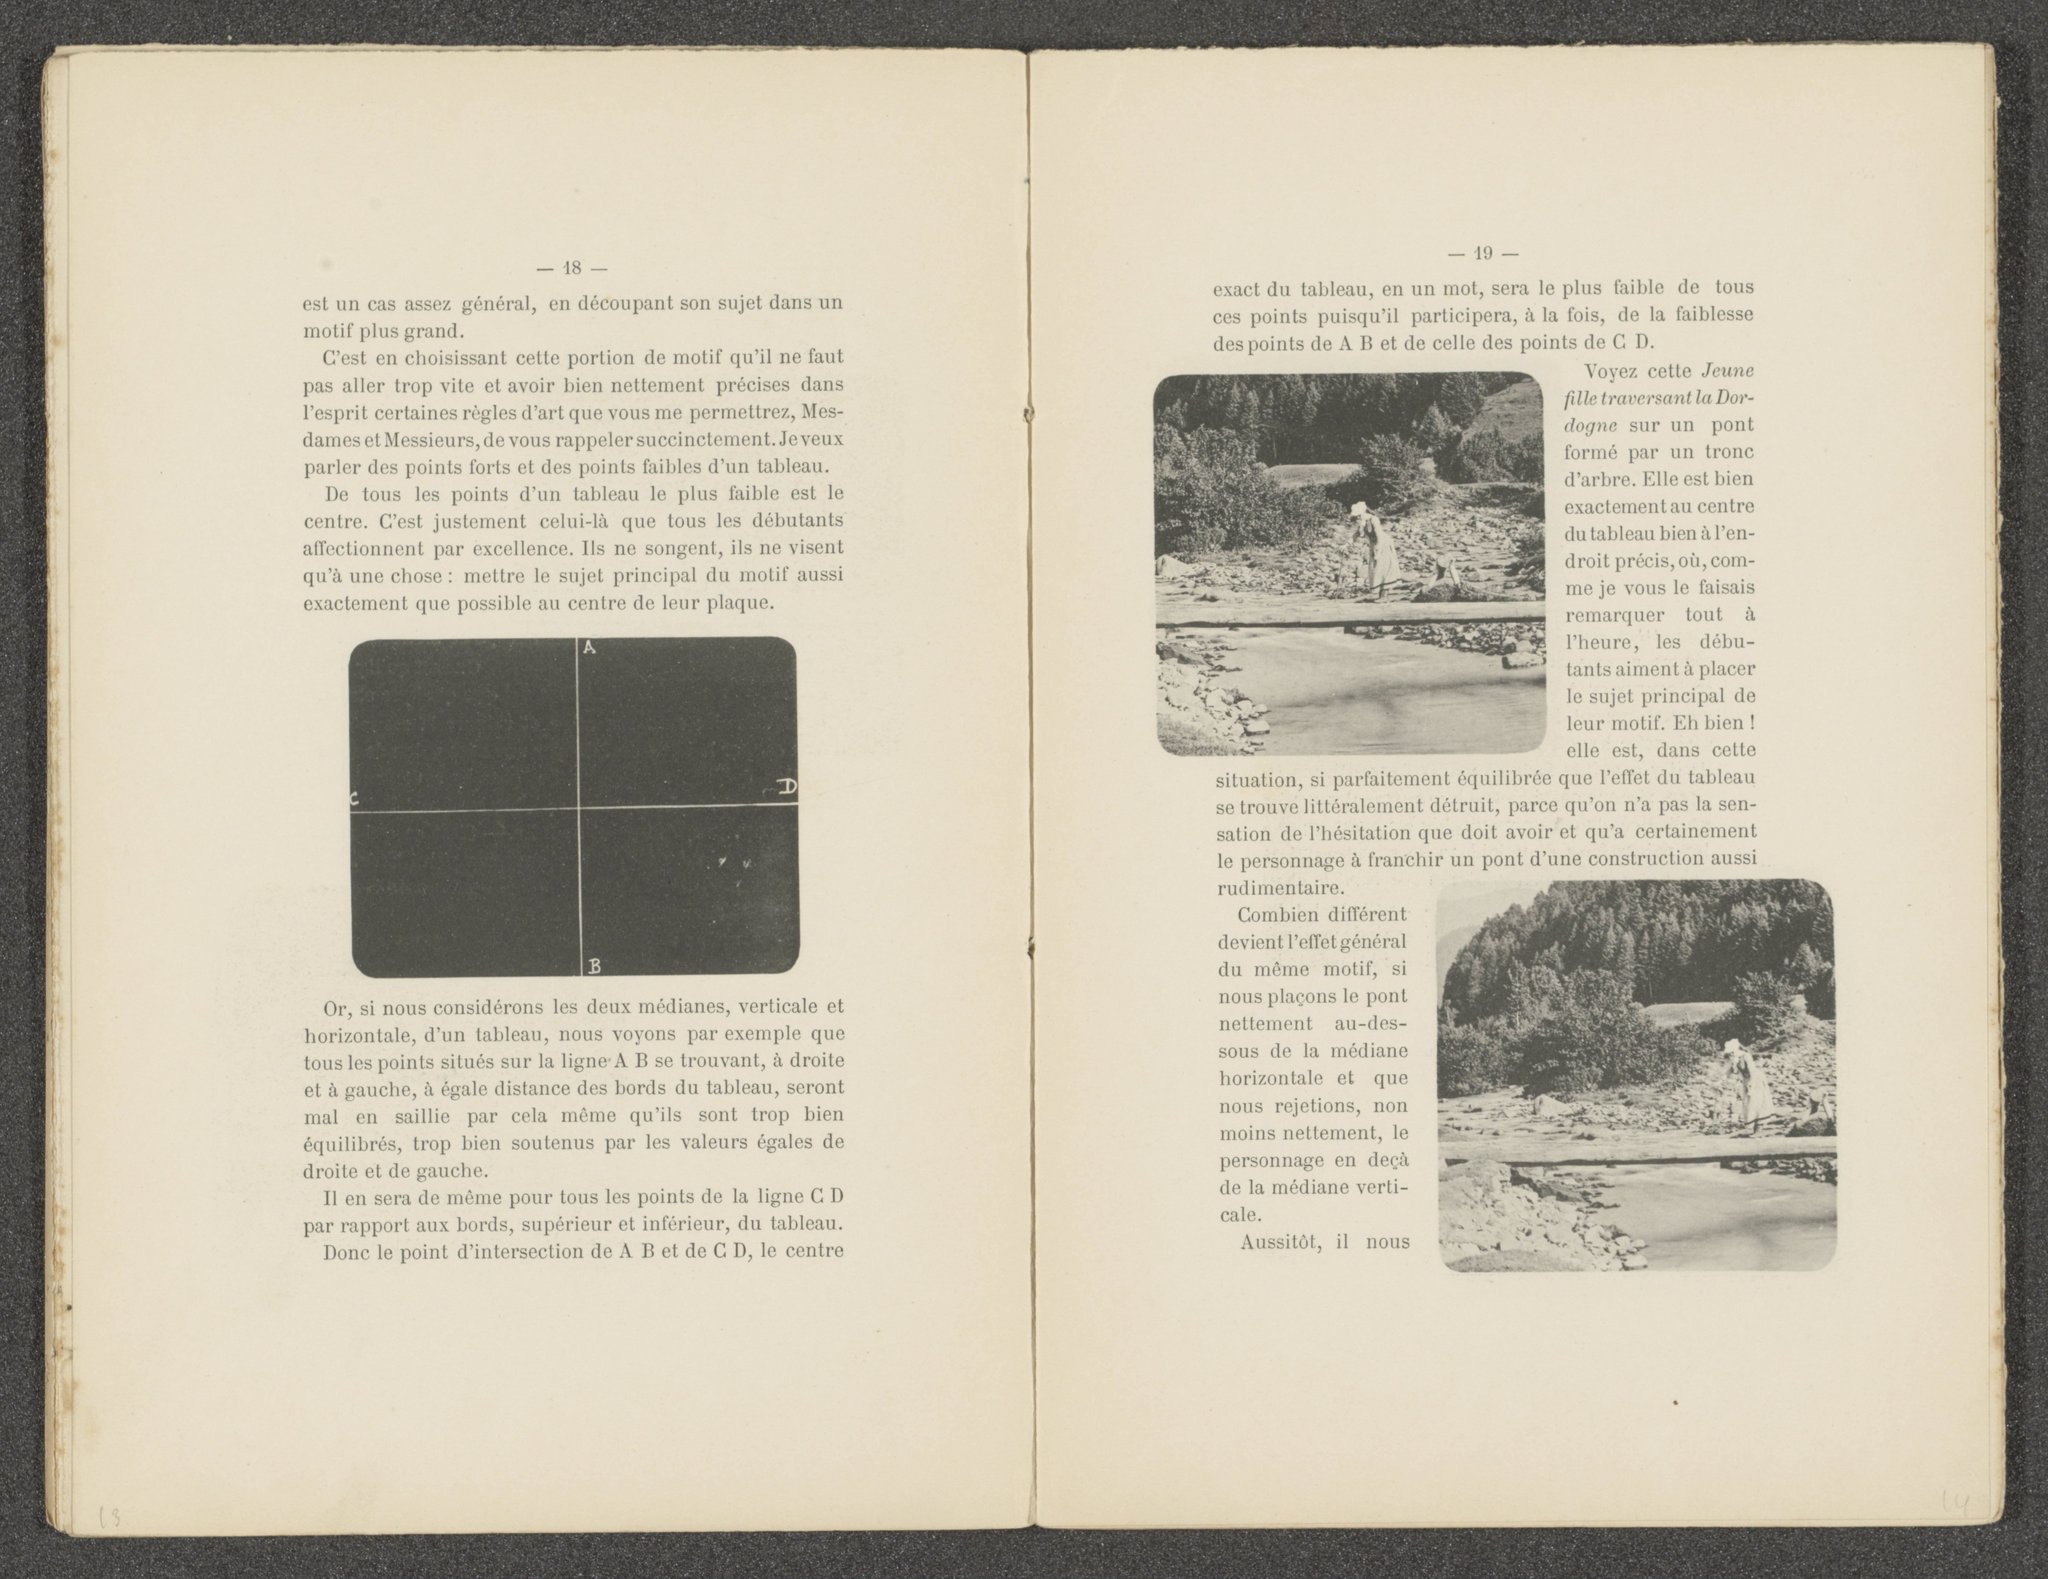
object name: photomechanical print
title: Vrouw op een boomstam over een beek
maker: Anonymous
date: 1886-1896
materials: paper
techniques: photograph, printing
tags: brook, beam, log of wood